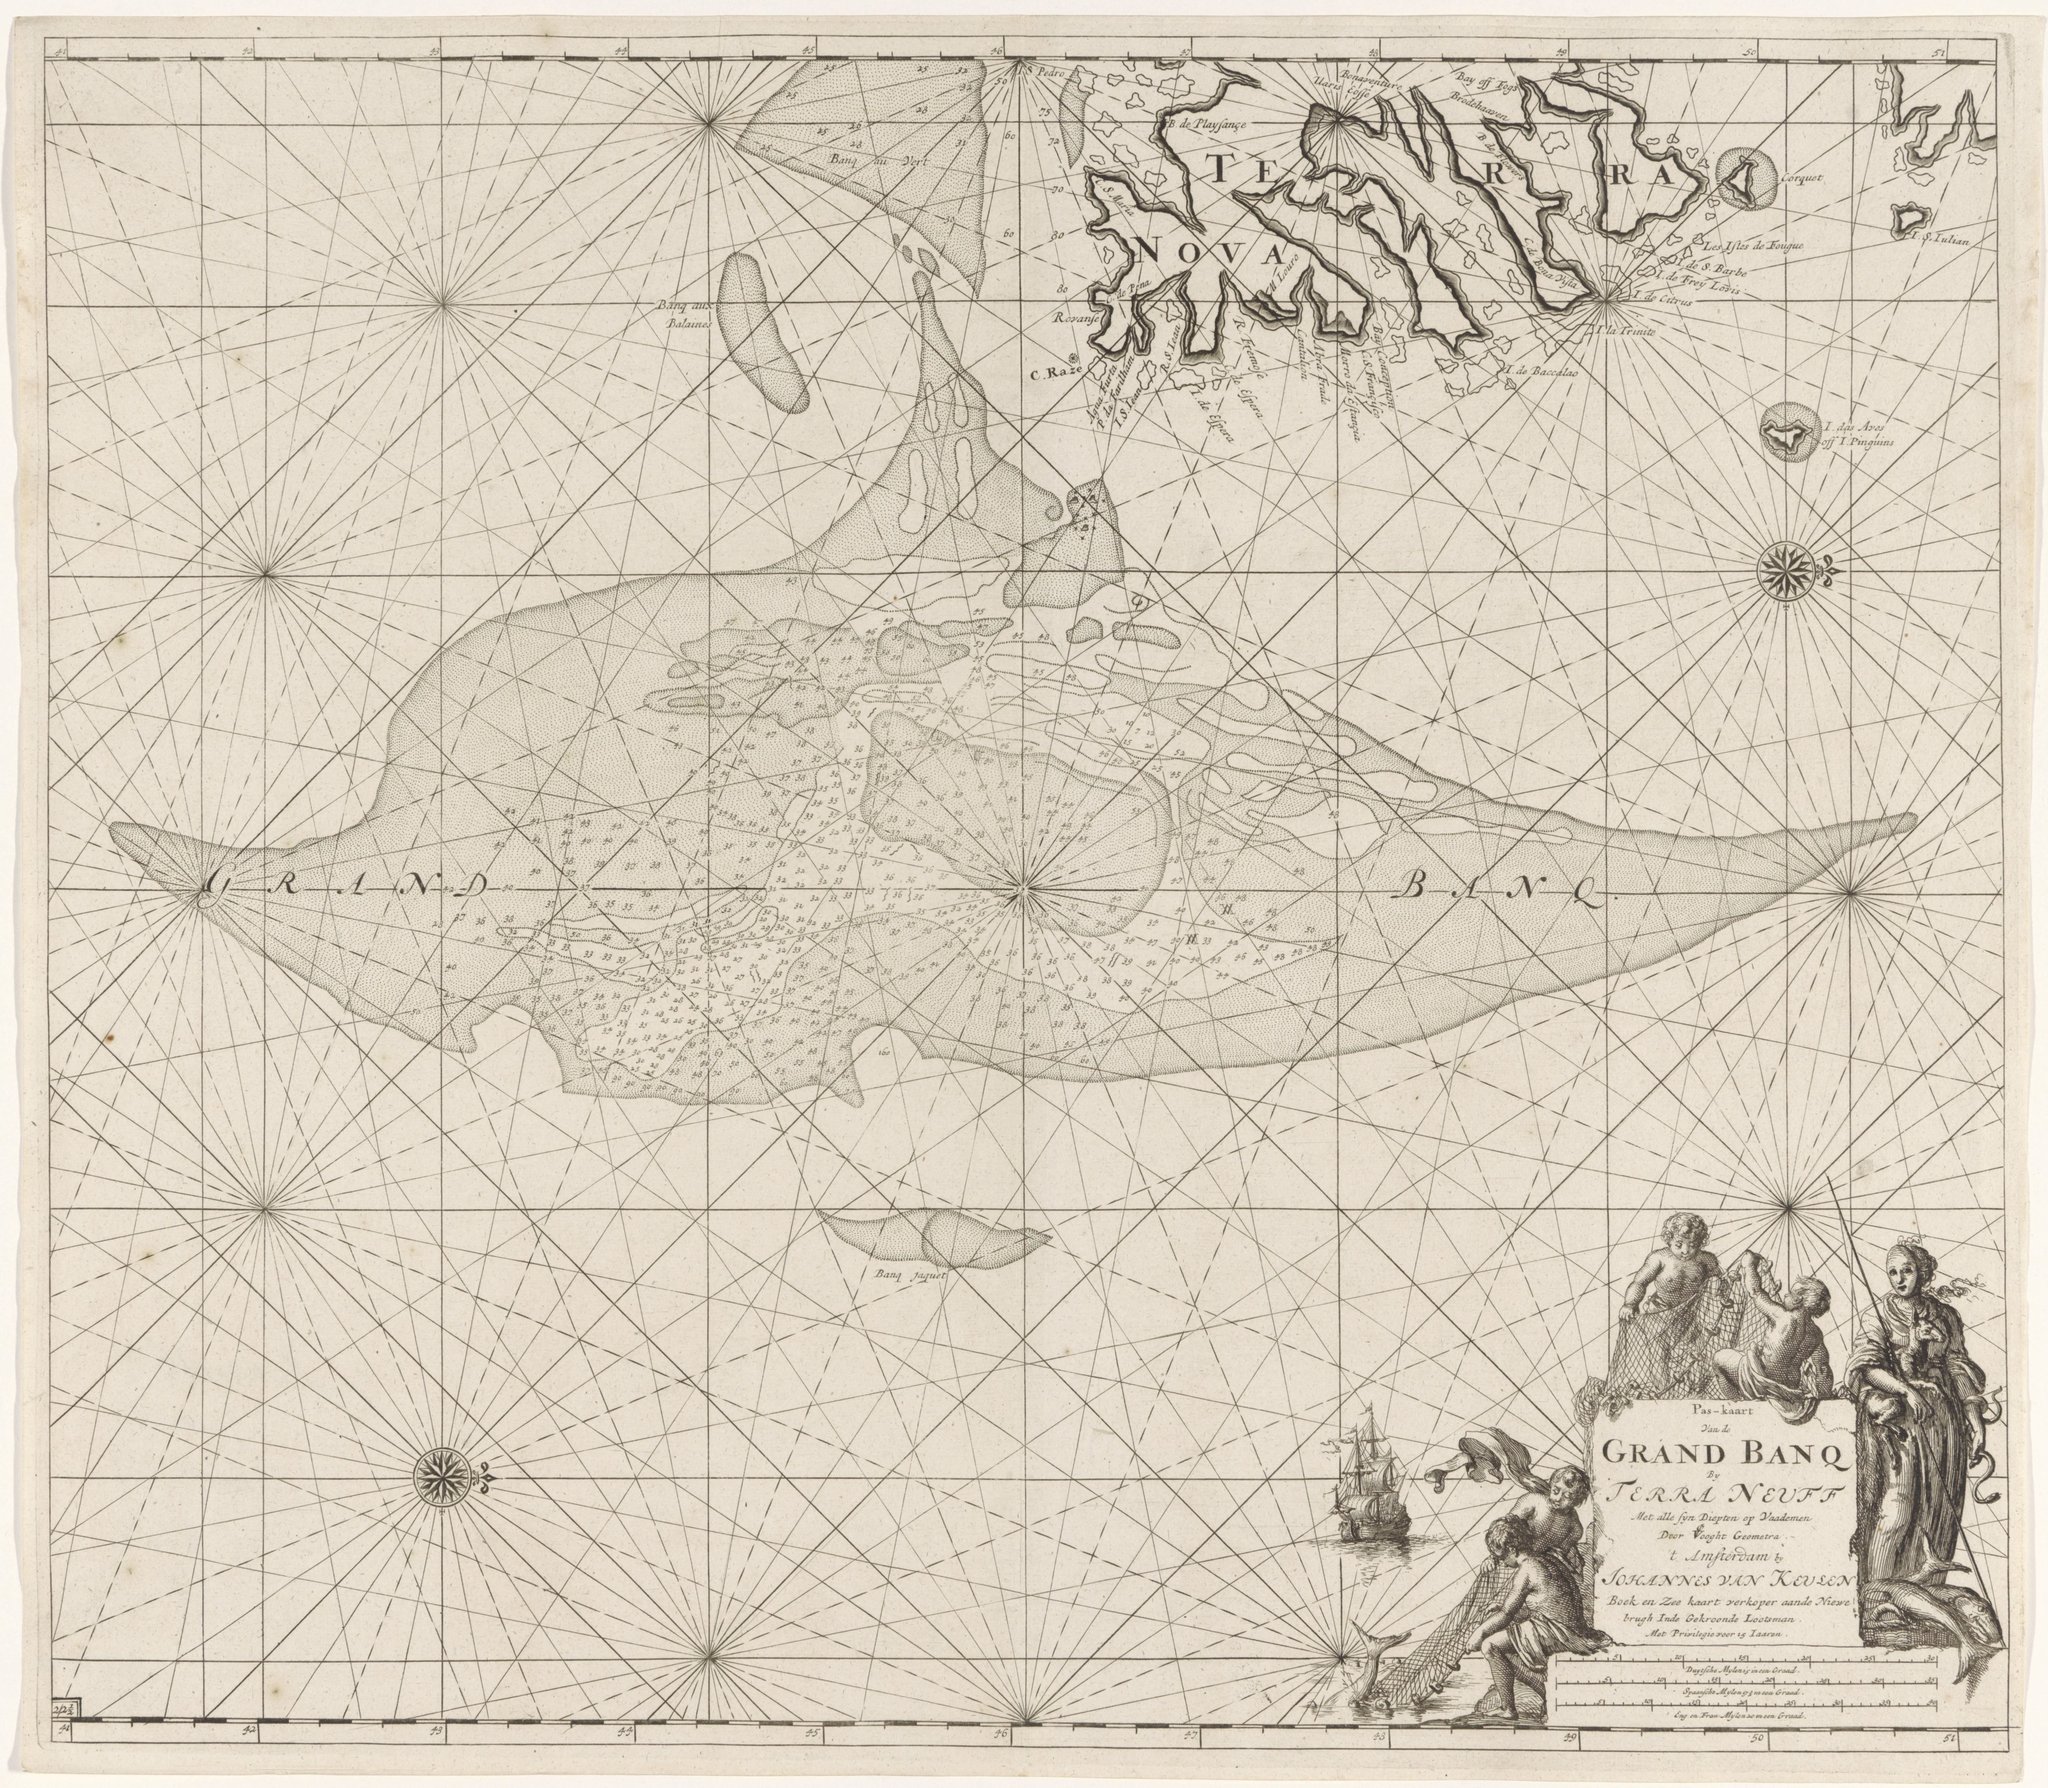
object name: print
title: Paskaart van de Grand Banks bij Newfoundland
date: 1684-1799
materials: paper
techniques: engraving, etching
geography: amsterdam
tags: mask, snakes, sailing-ship, sailing-boat, angling, sea and coastal fishery, beasts of prey, predatory animals: fox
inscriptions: collector's mark: Lugt 2228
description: Paskaart van de Grand Banks bij Newfoundland met de zuidkust van Newfoundland, met twee kompasrozen, het Noorden ligt links. Rechtsonder de titel, het uitgeversadres en de schaalverdeling, weergegeven in Duitse, Spaanse en Engelse of Franse mijlen. De gegevens zijn versierd met vissende jongens met een visnet en een vrouw met een masker, een hengel, een slang en een vos. Aan haar voeten staat een mand gevuld met vissen.